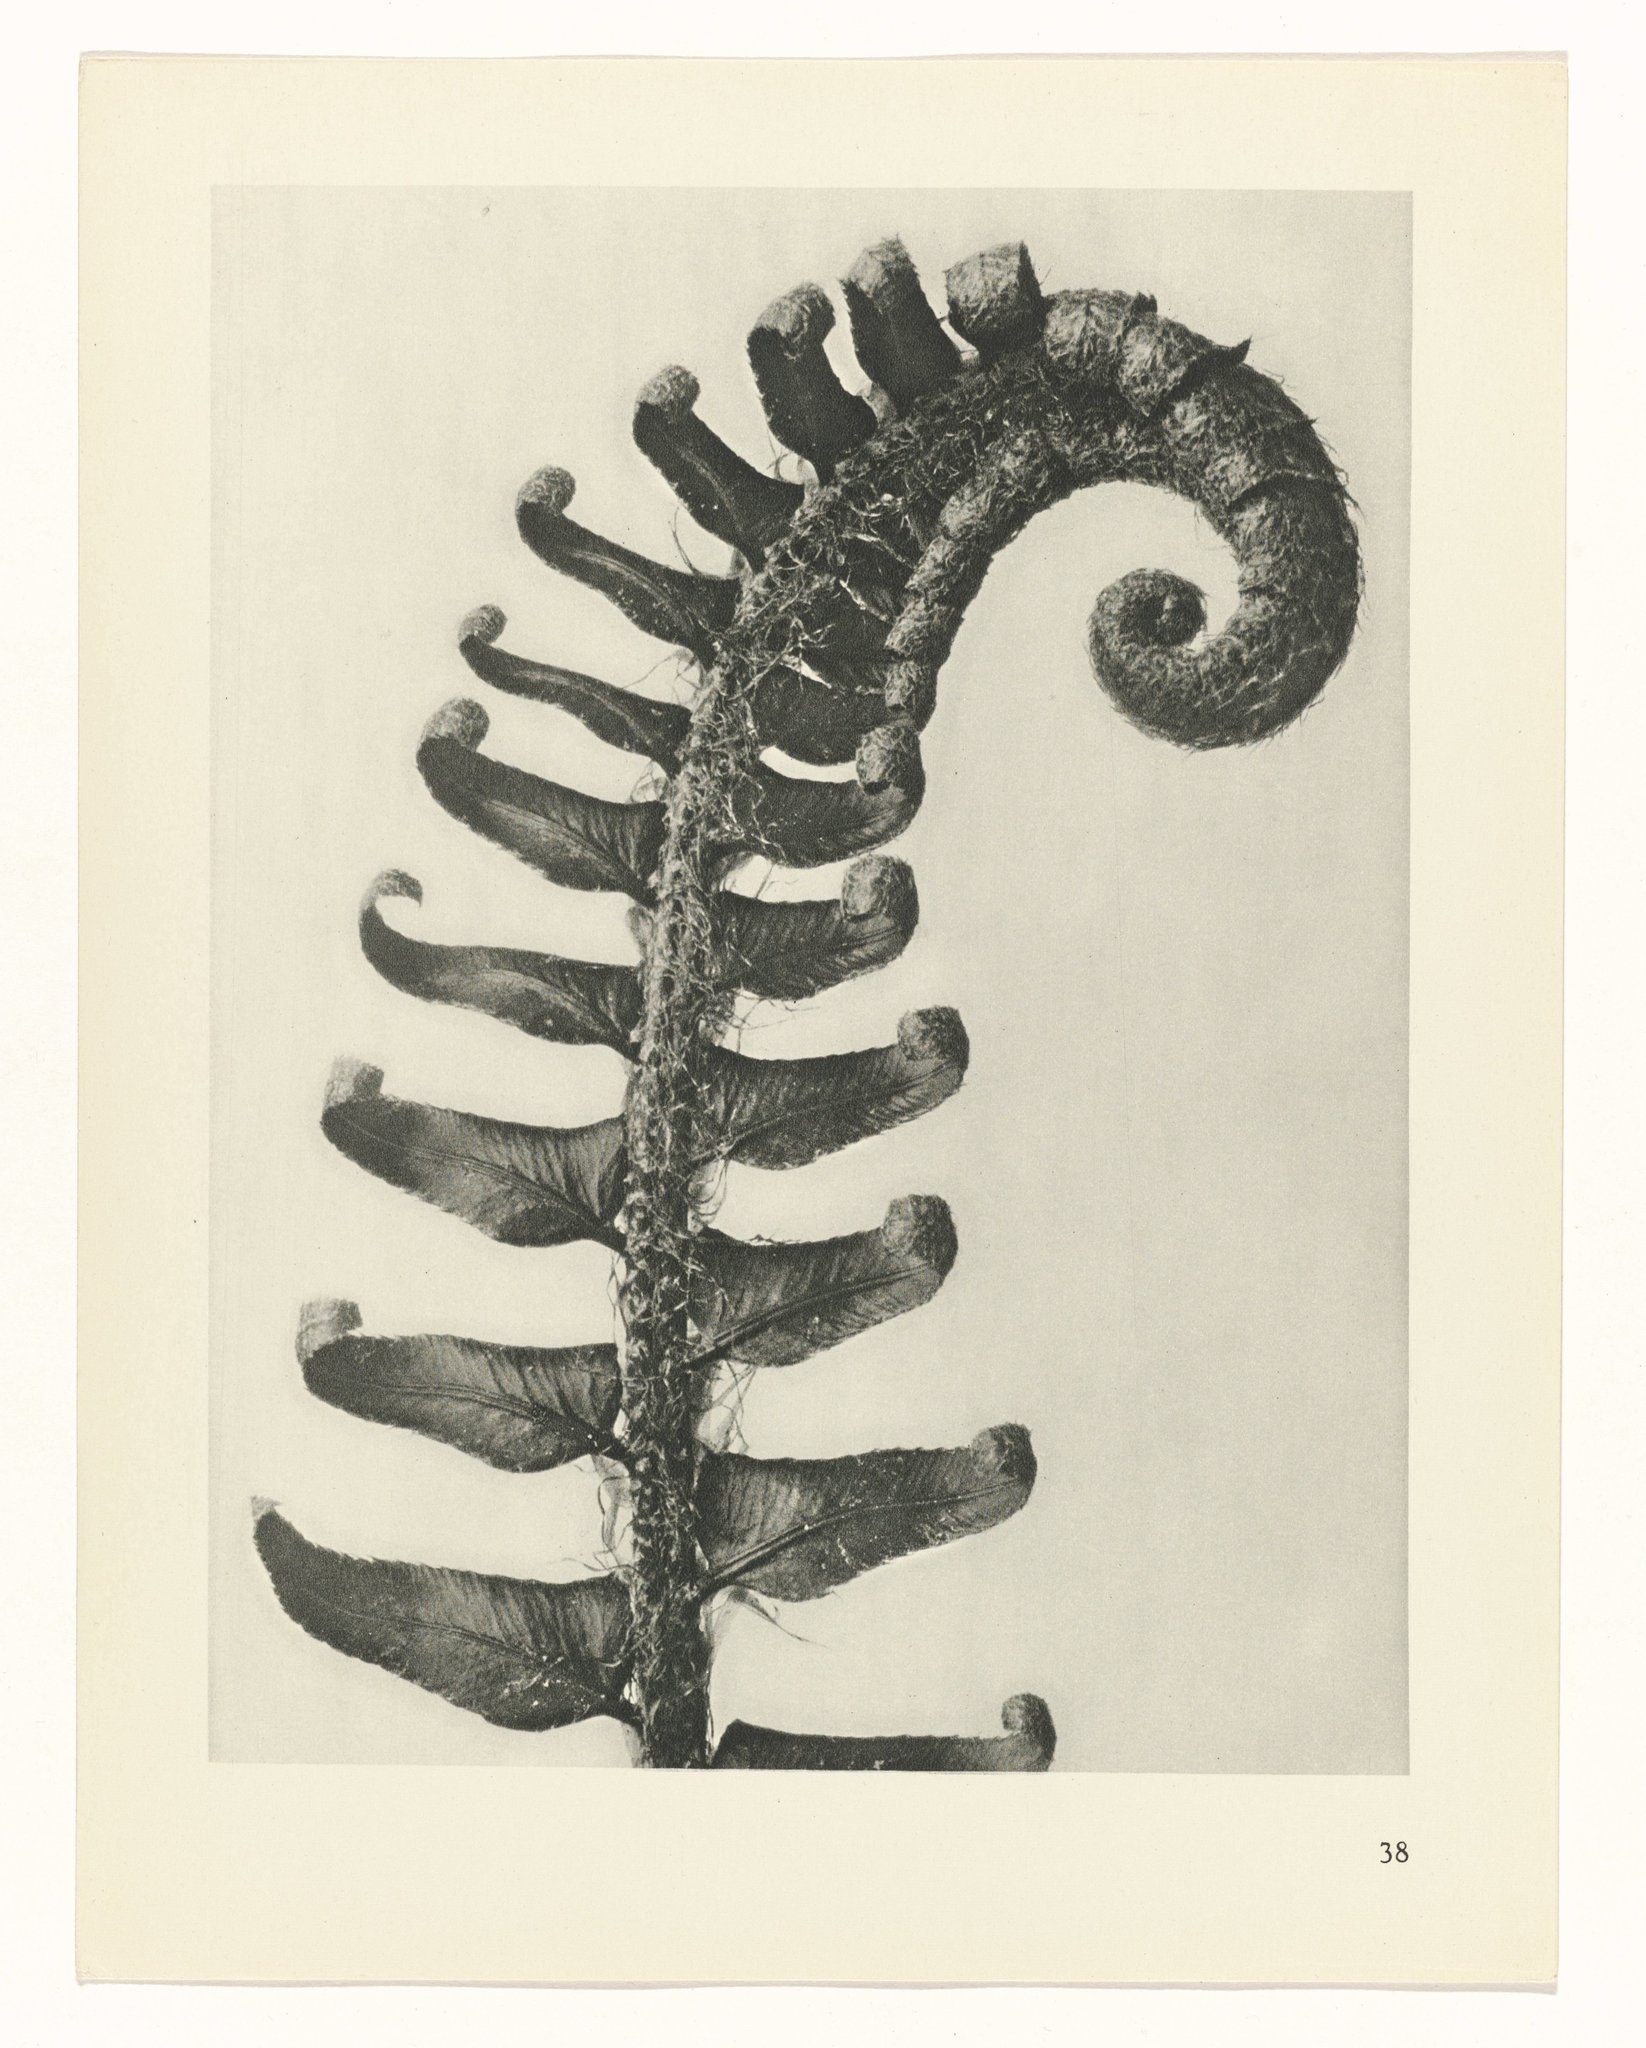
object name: photograph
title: Plantstudie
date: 1928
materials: ink, paper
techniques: rotogravure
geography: berlin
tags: plants (in general)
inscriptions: number: ‘38’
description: facher Vergrößerung. Afkomstig uit losbladige uitgave.